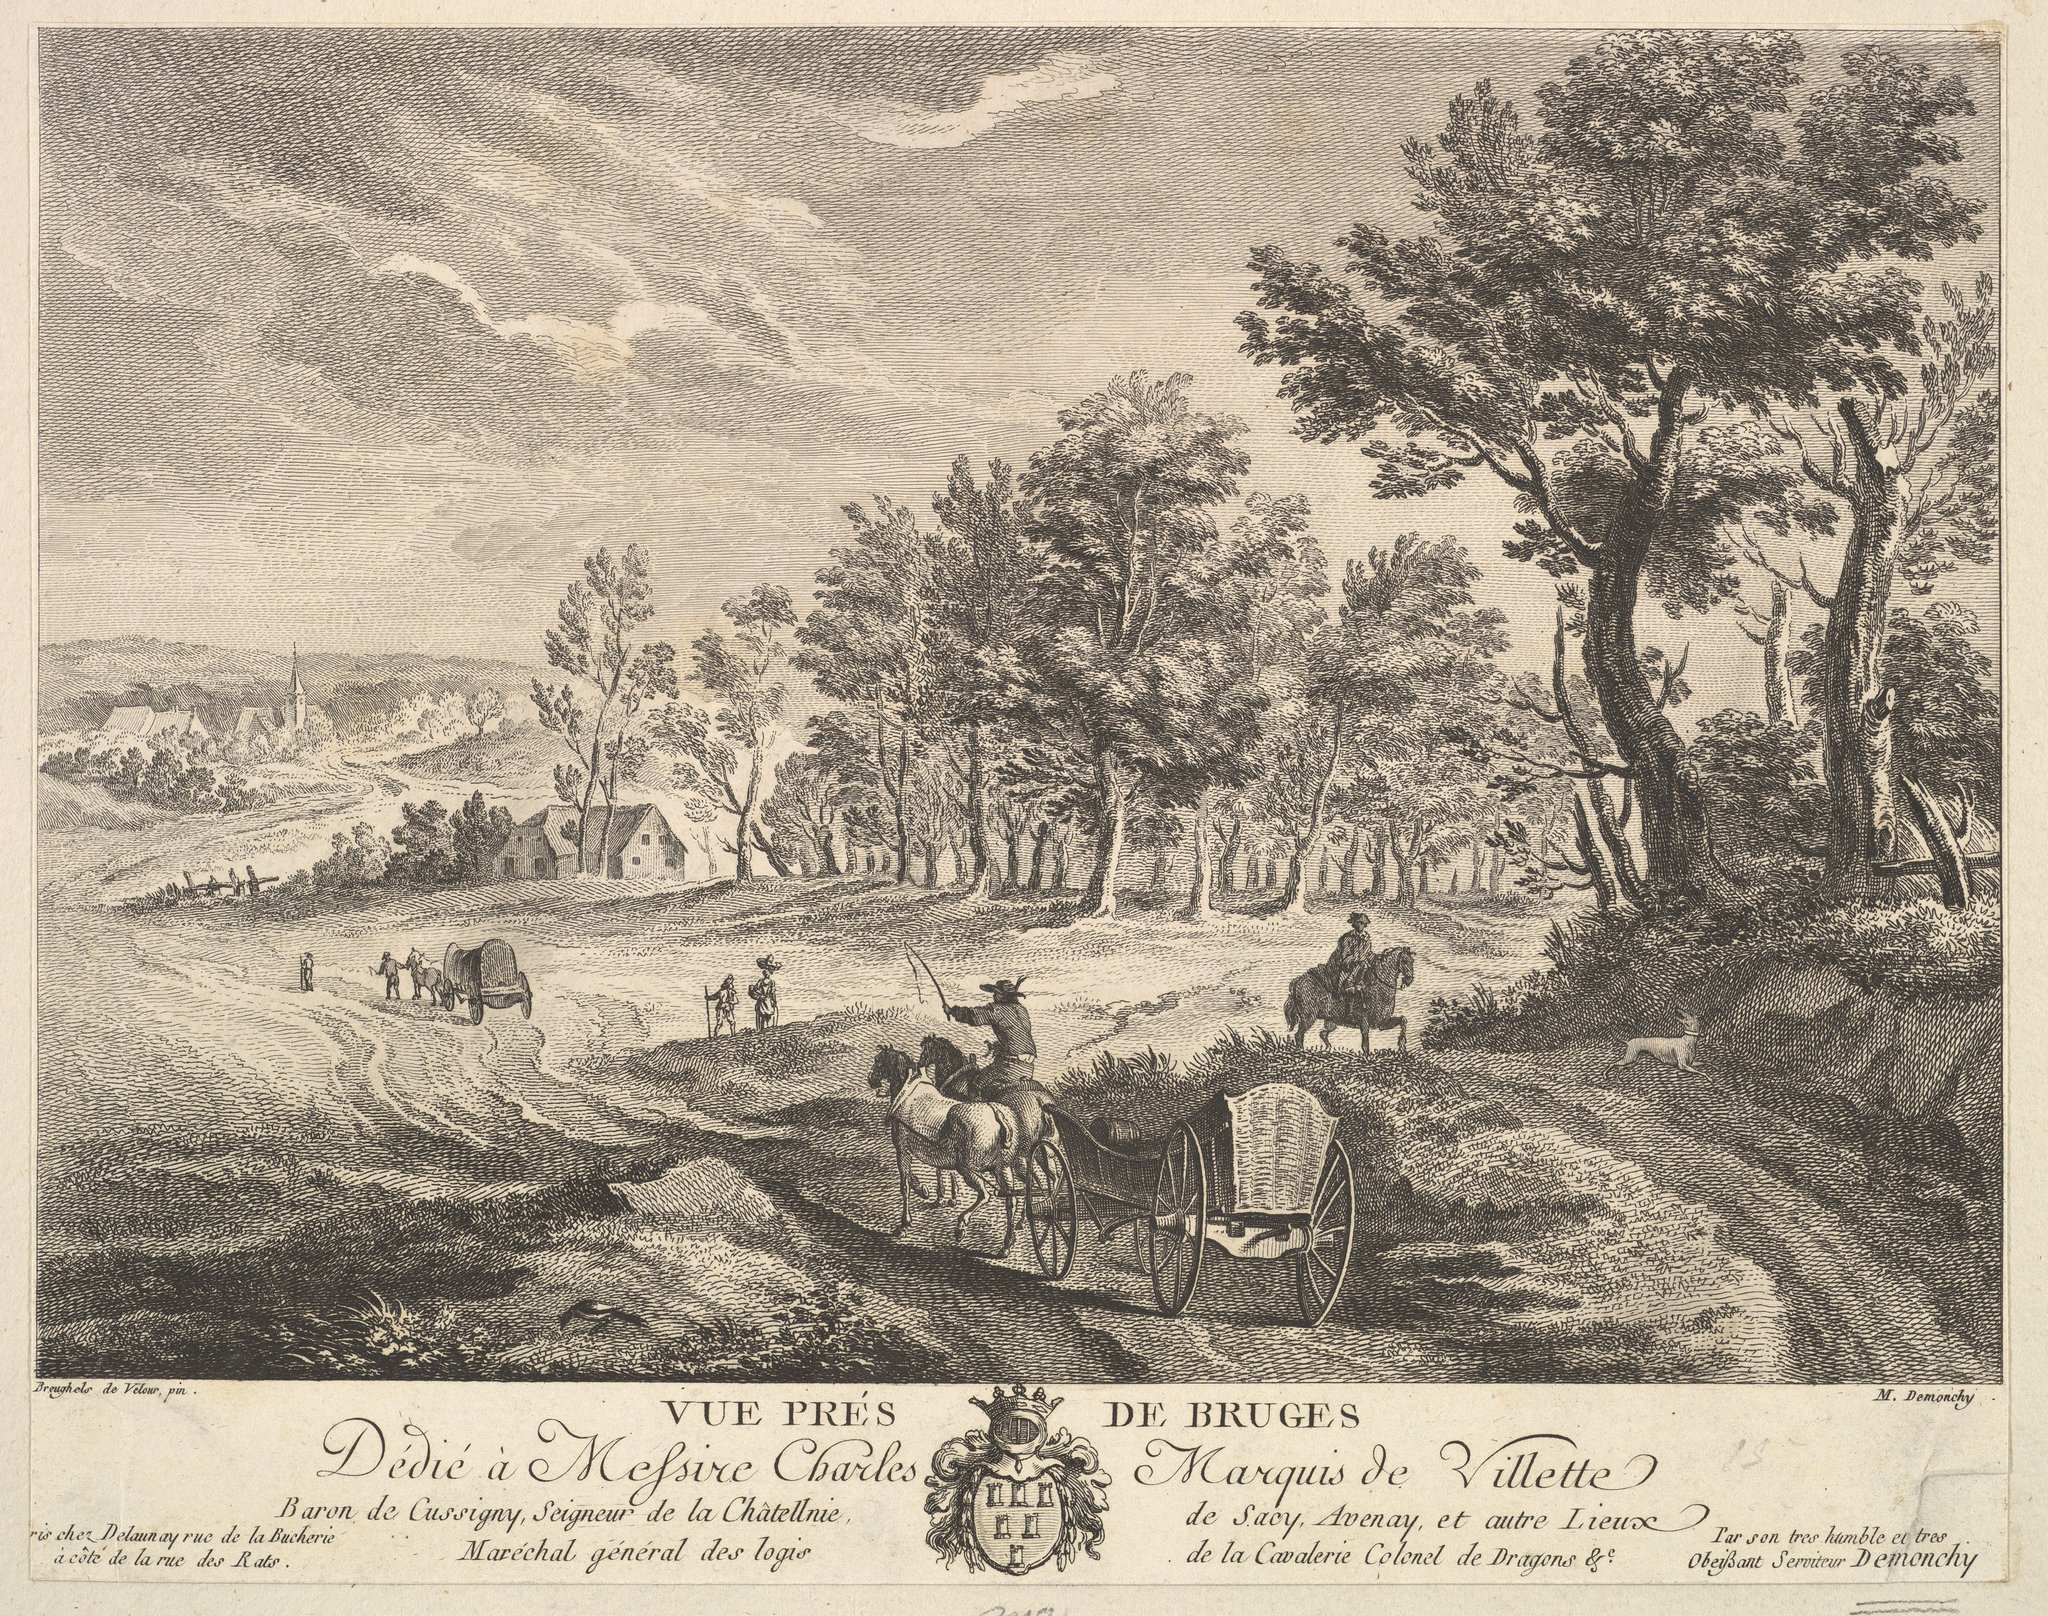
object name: print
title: View near Bruges (Vue Prés [sic] de Bruges)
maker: martin de monchy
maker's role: artist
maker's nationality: french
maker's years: 1746-1815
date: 1746-1830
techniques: engraving, etching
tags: horses,landscapes,trees,carriages